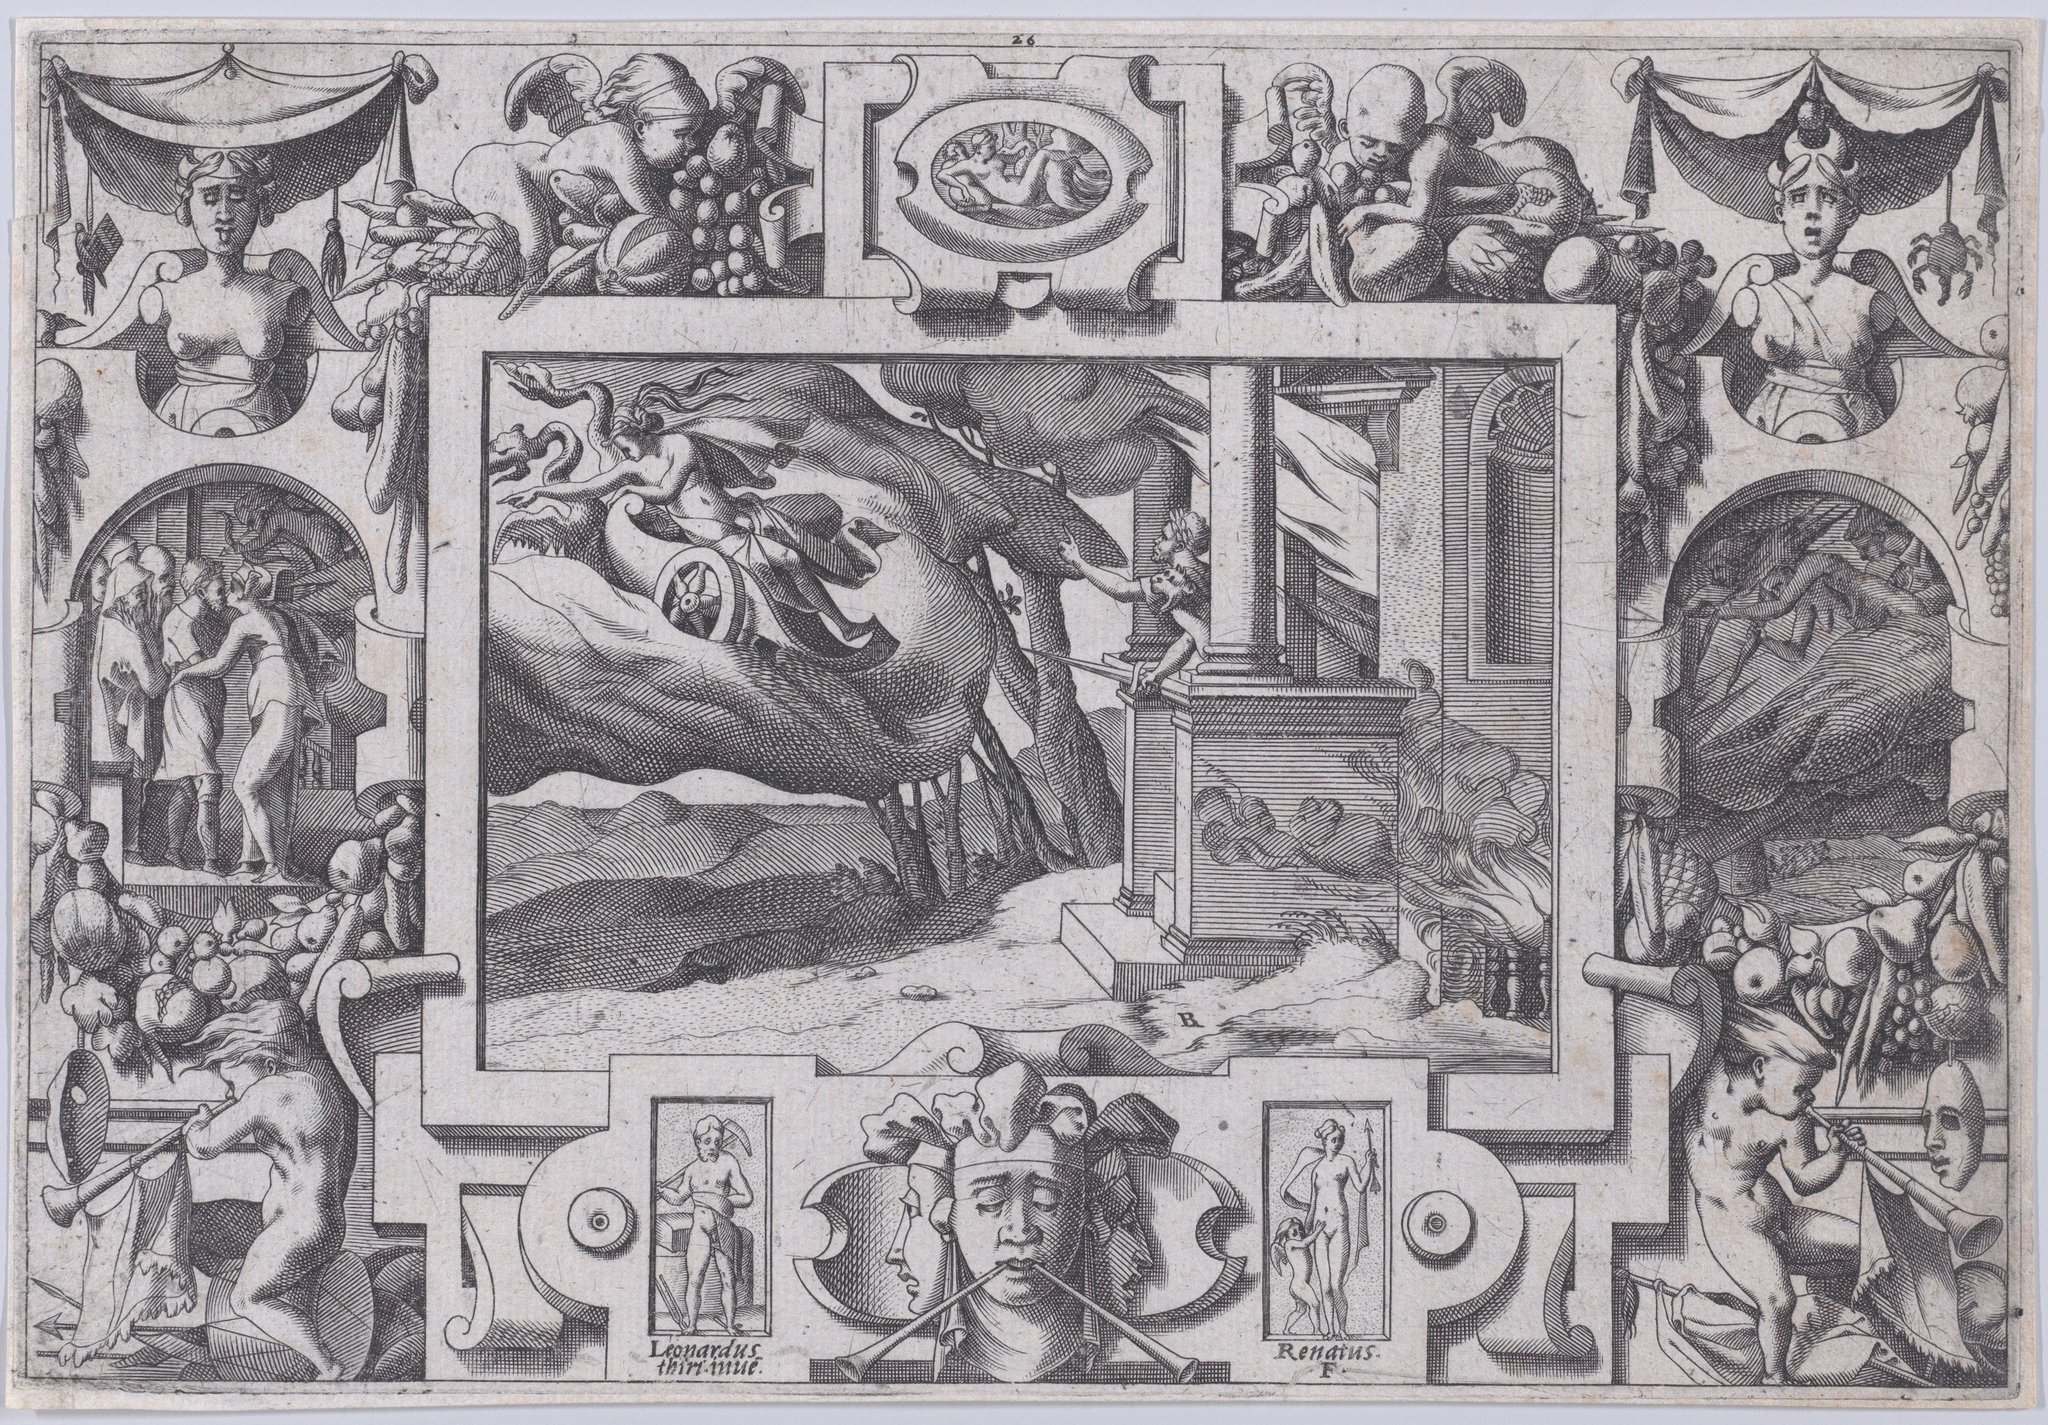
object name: print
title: Medea Flees from Jason (L'épée au poing court Jason la poursuivre mais ne peut celle en vitesse aconsuivre...), from "Jason and the Golden Fleece"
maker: rené boyvin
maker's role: artist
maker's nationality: french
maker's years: 1525-1598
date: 1563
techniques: engraving